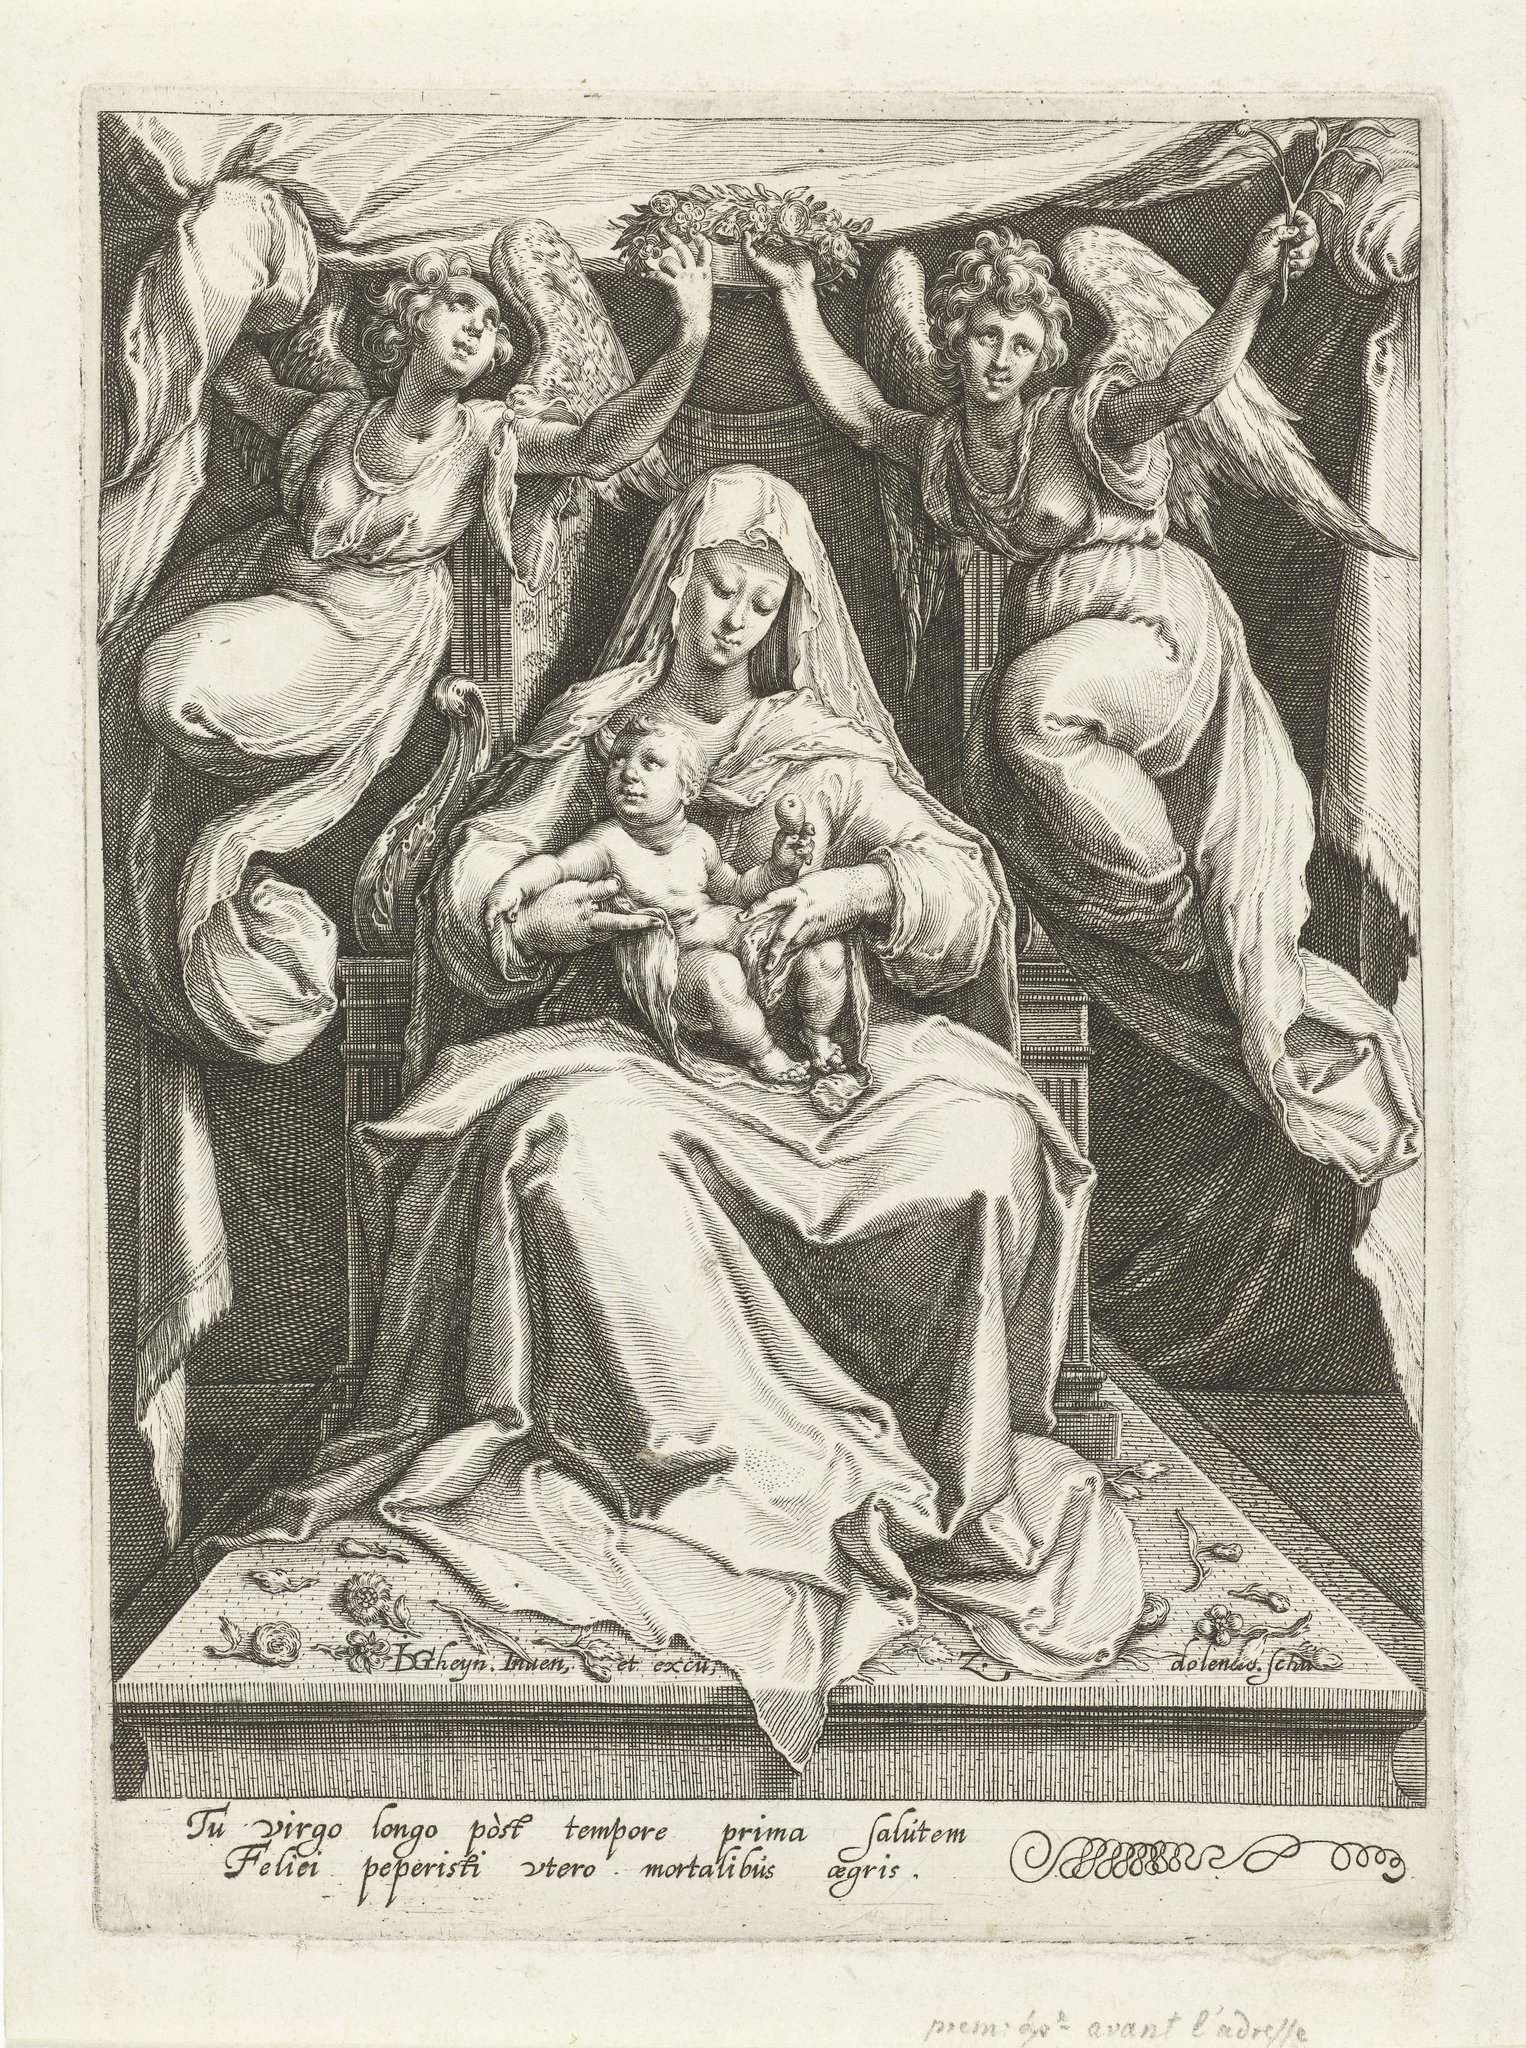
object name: print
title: Tronende Maria met Kind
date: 1595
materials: paper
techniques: engraving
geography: leiden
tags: mary sitting or enthroned, the christ-child in front of her in her lap (or in front of her bosom) (+ angel(s))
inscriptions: inscription: ‘Mawet’, collector's mark: Lugt 2228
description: Maria zit op een troon, het Kind in haar schoot. Twee engelen houden een bloemenkrans boven haar hoofd. Op het bodes waarop haar troon staat liggen strooibloemen. Onder de voorstelling een Latijns vers.